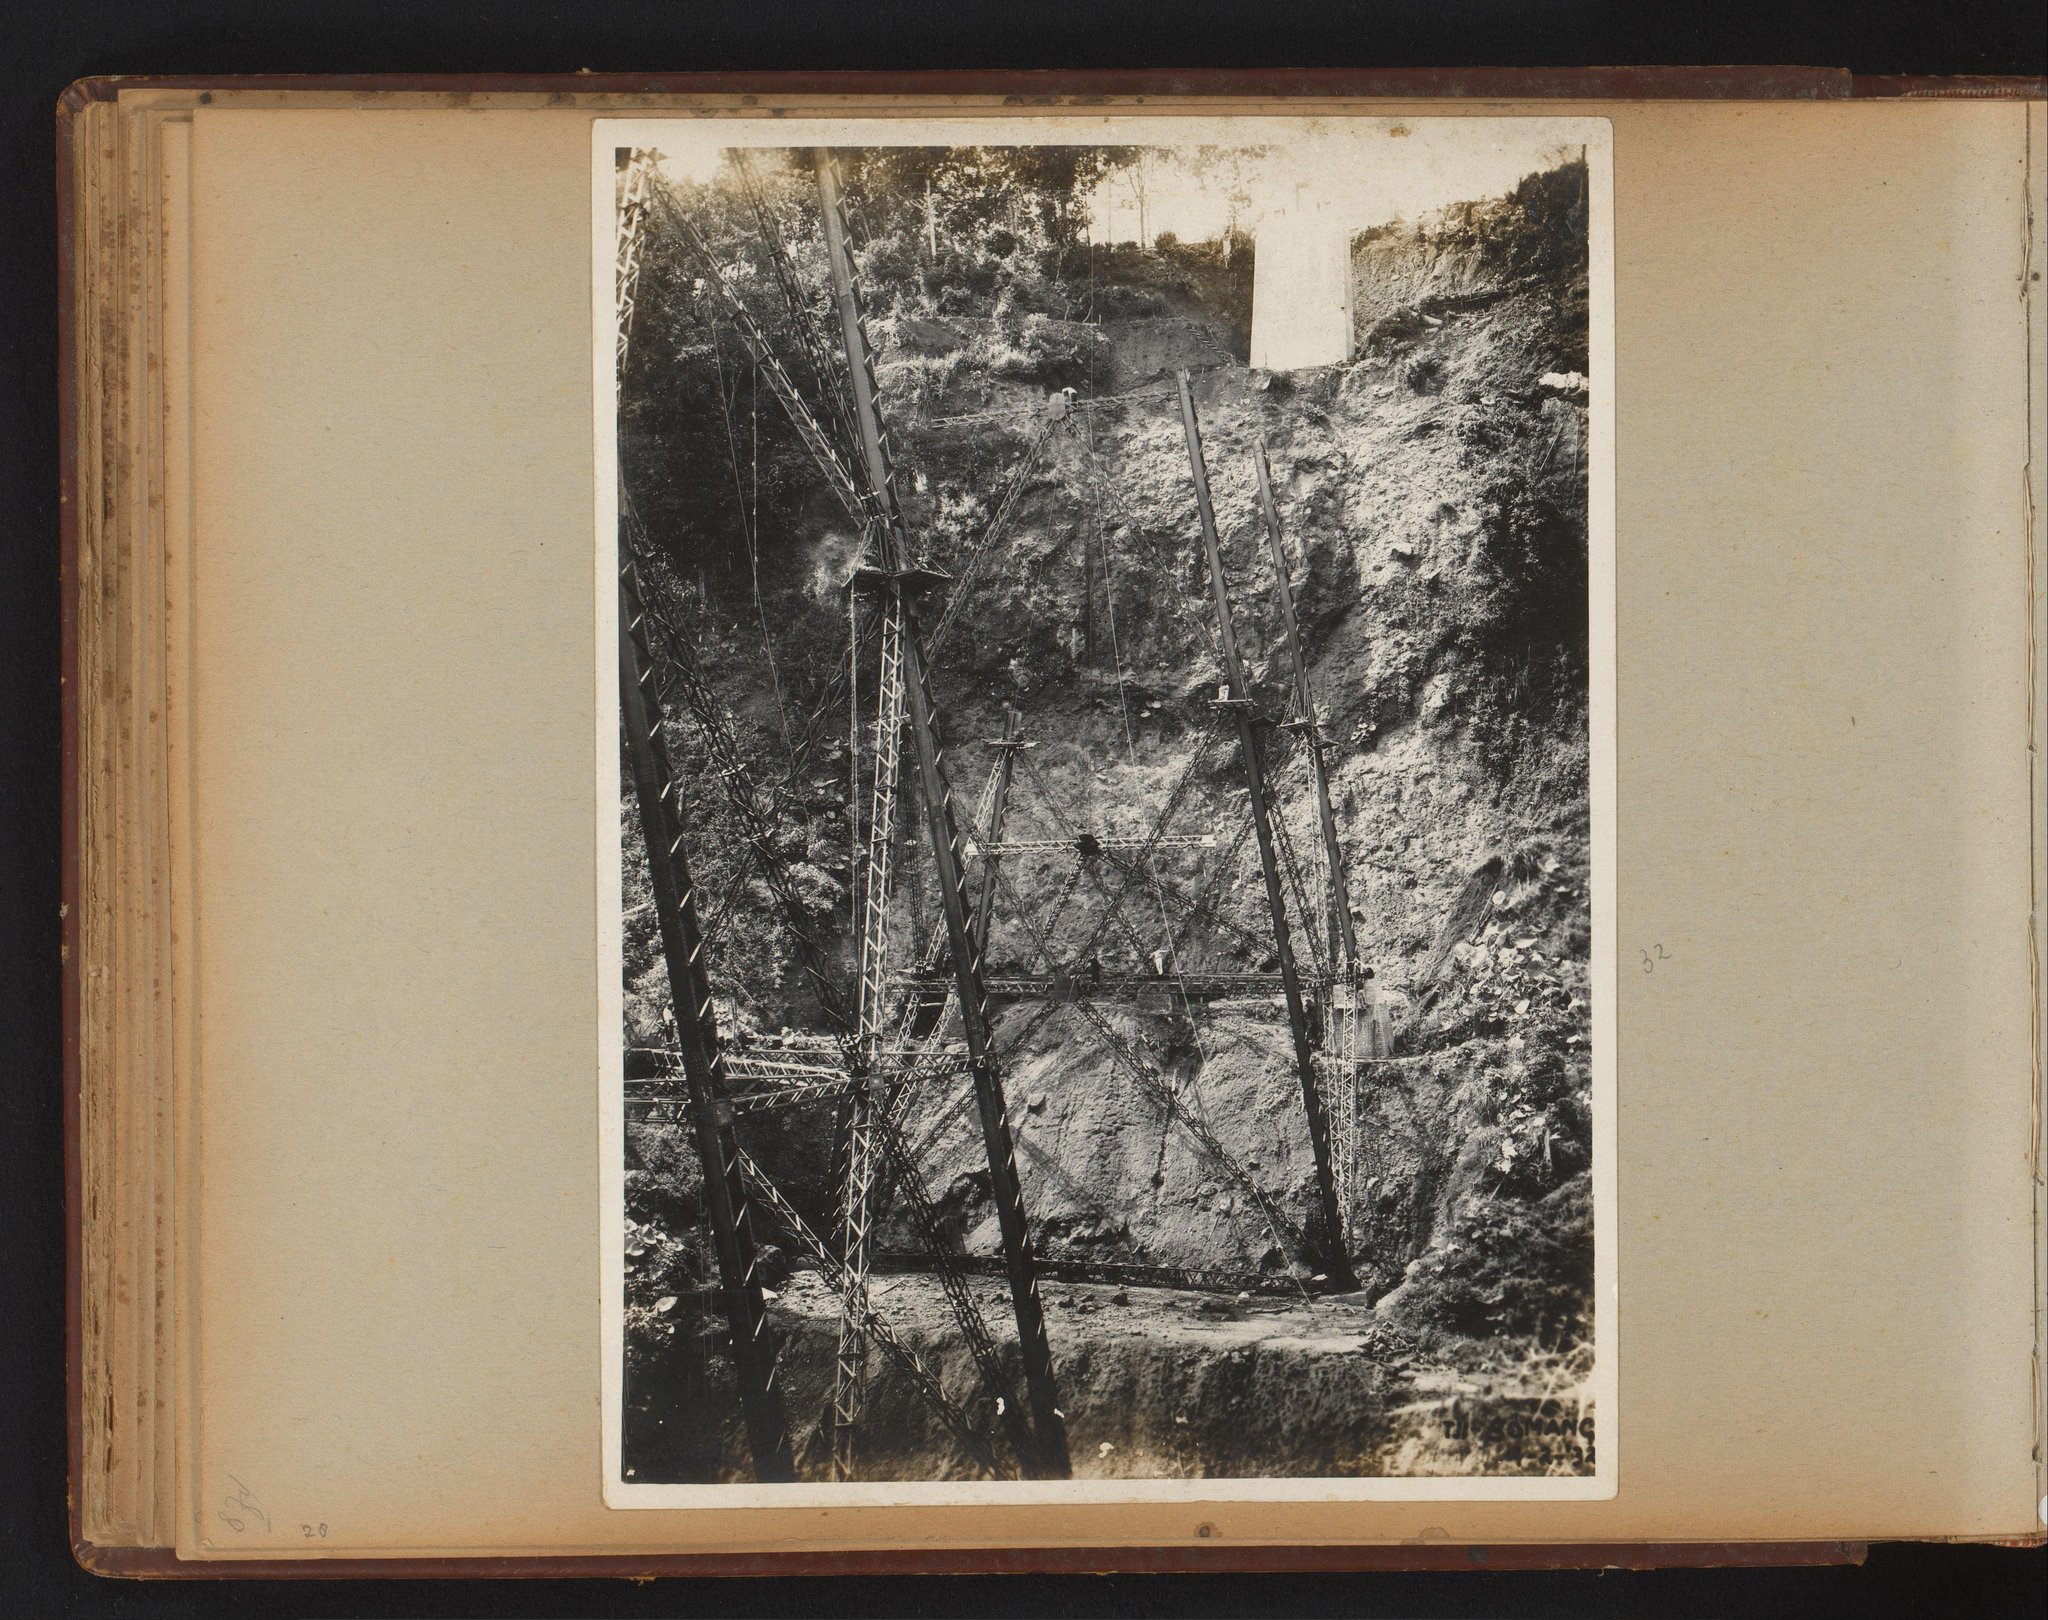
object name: photograph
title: Spoorbrug over de Ci Somang in aanbouw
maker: Anonymous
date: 1932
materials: cardboard, photographic support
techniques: gelatin silver print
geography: preanger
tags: railway, tramway; rack railway, bridge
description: Albumblad met een foto van de spoorbrug over de Ci Somang in Preanger in aanbouw in 1931-1932. De drie pijlers zijn geleverd in 1931 door Machinefabriek Braat. Onderdeel van een fotoalbum met foto's van machines en constructies van de N.V. Machinefabriek Braat te Soerabaja, Soekaboemi en Tegal uit de periode 1931-1937.